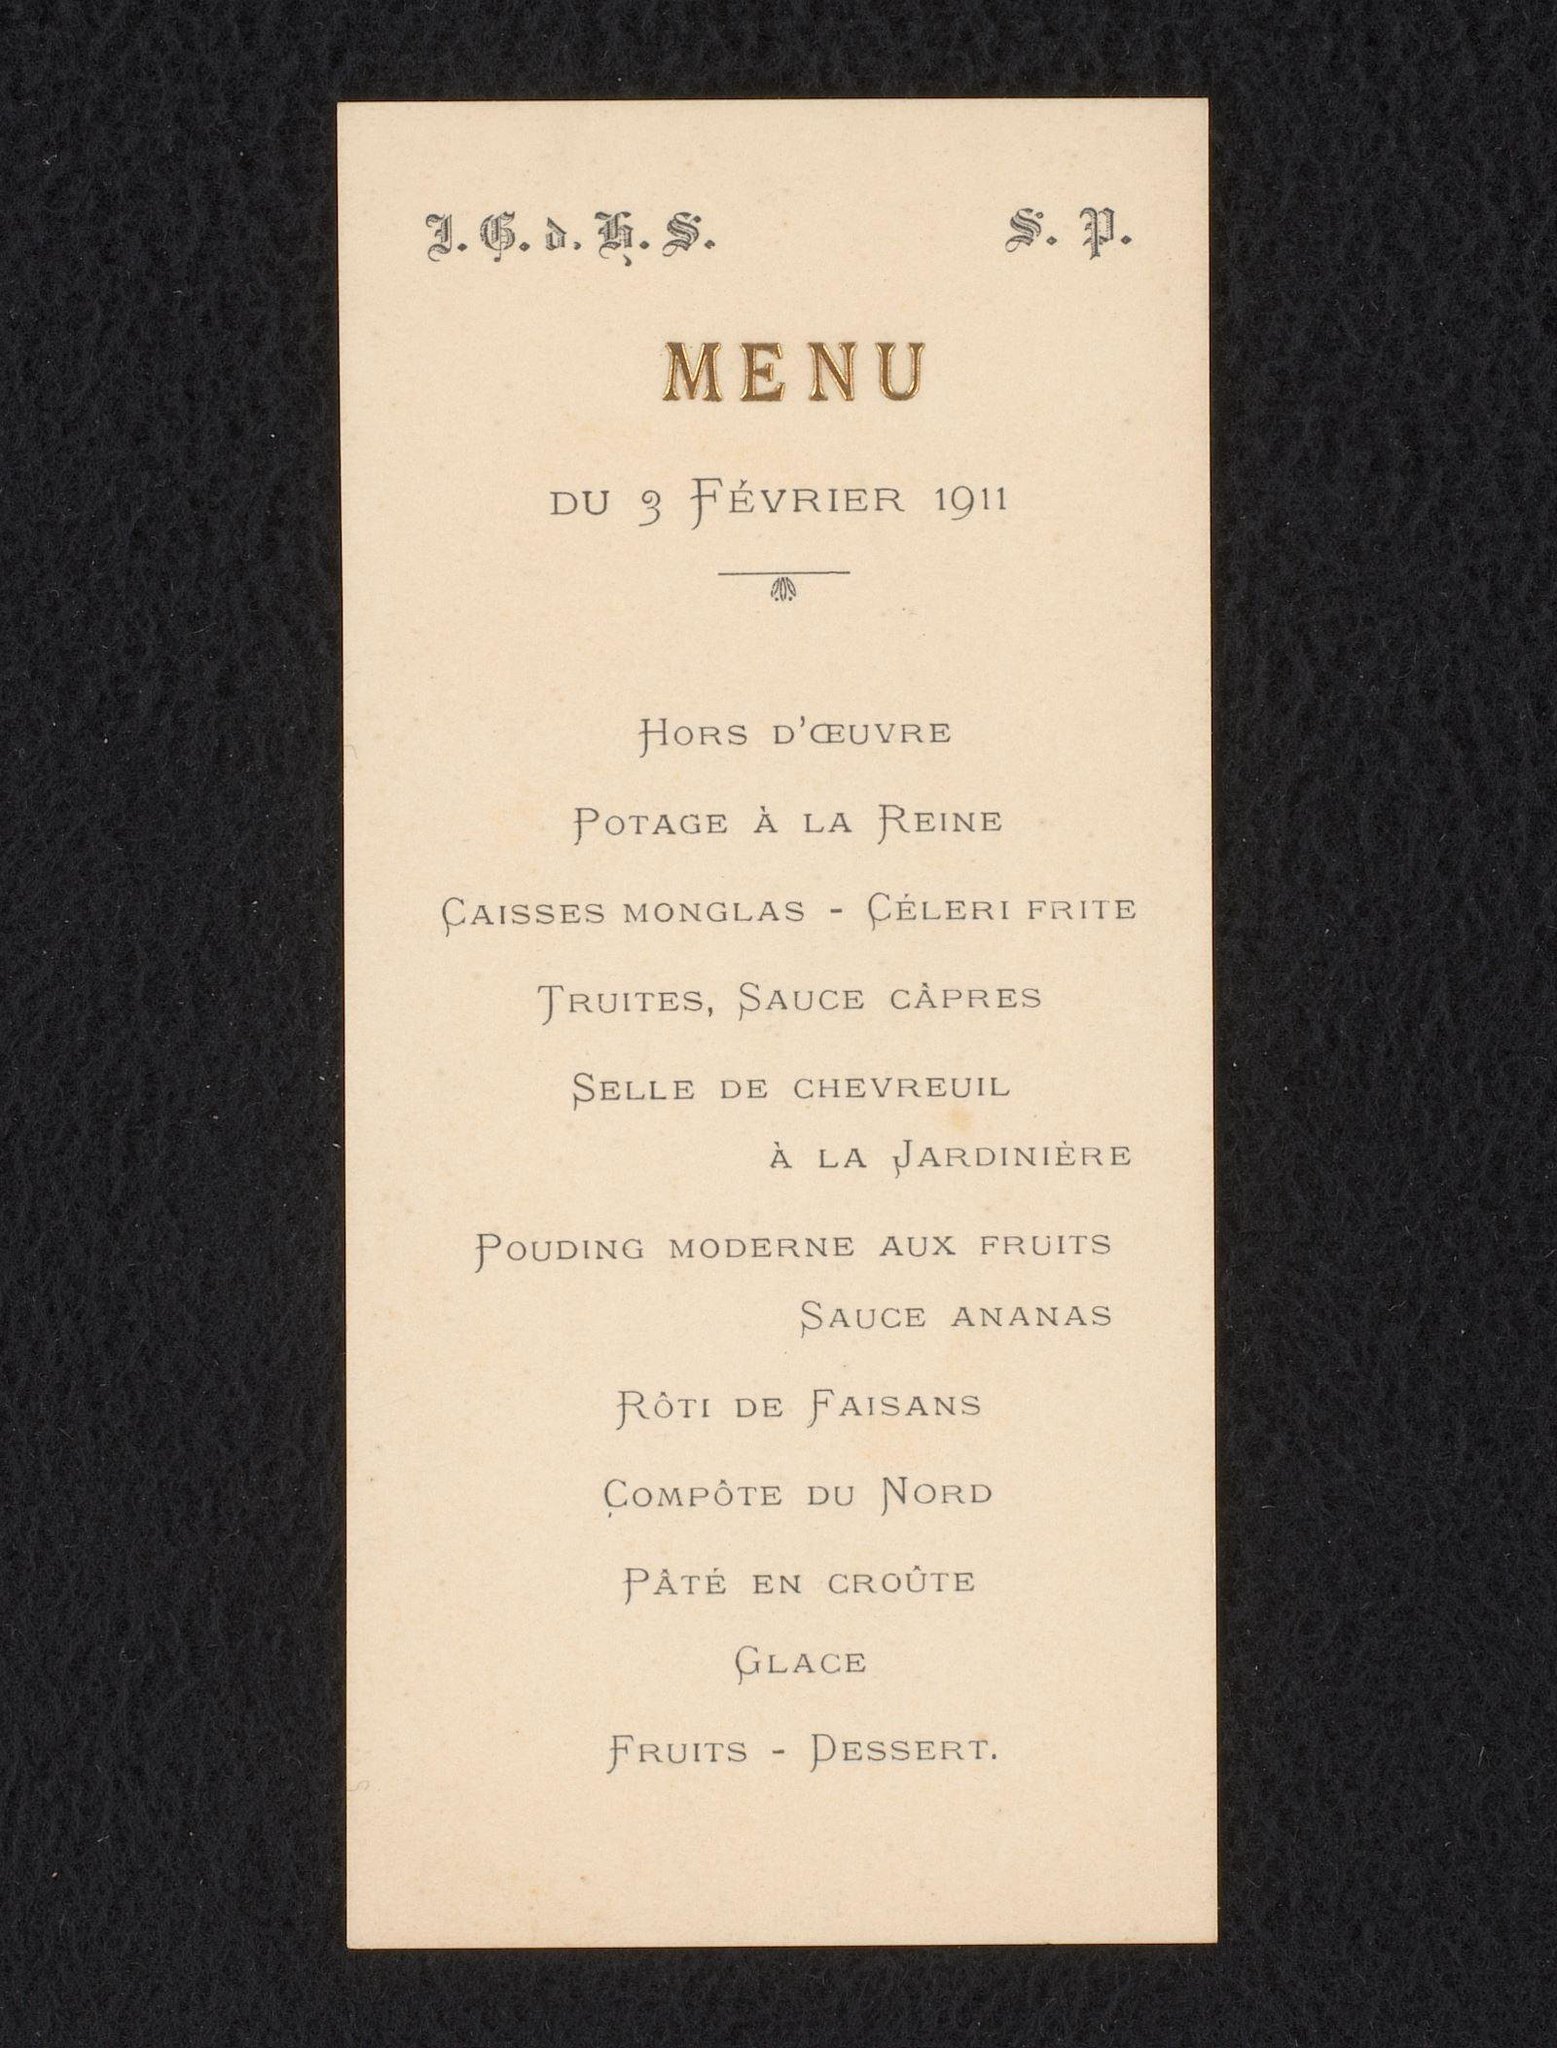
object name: menu, menukaart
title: Menukaart voor een diner op 3 februari 1911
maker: Anonymous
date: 1911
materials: paper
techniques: blind stamped, letterpress printing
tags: 43b311(+12)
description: Bij gebrek aan gegevens over de vervaardiger is voor de bepaling van de rechten van dit object gebruik gemaakt van de vervaardigingsdatum.